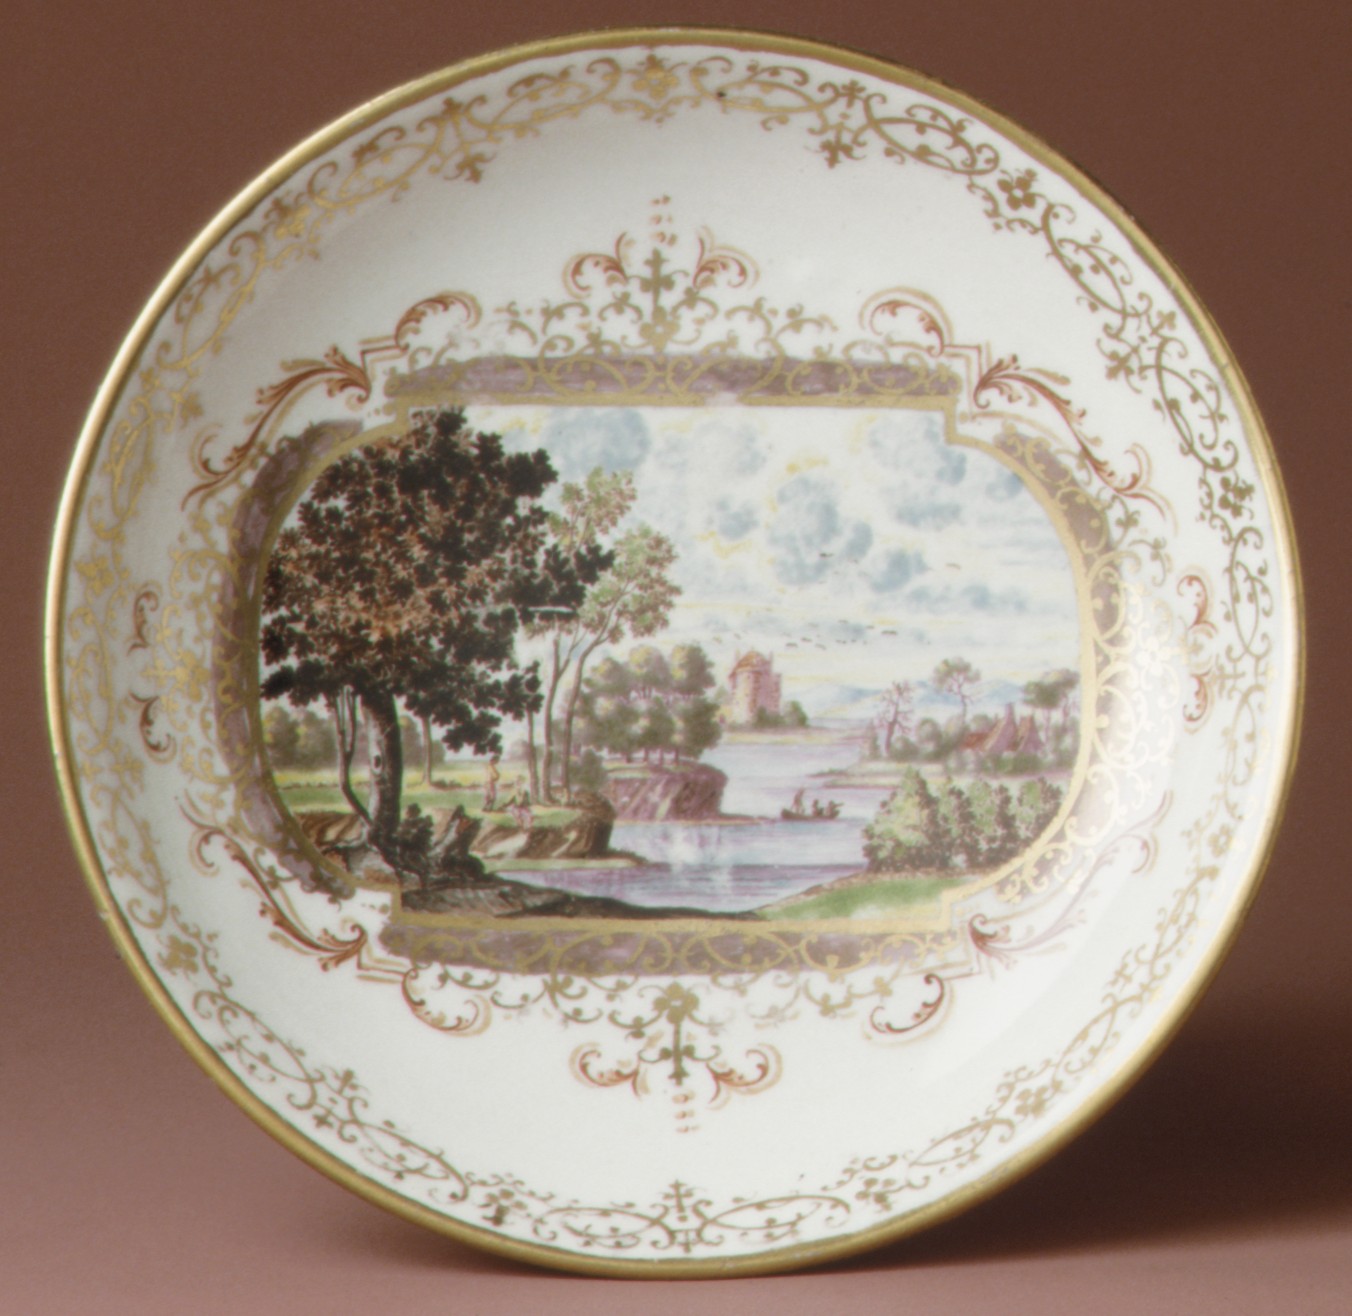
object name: saucer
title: Saucer (part of a set)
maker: meissen manufactory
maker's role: manufactory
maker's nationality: german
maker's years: 1710-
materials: hard paste porcelain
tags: landscapes